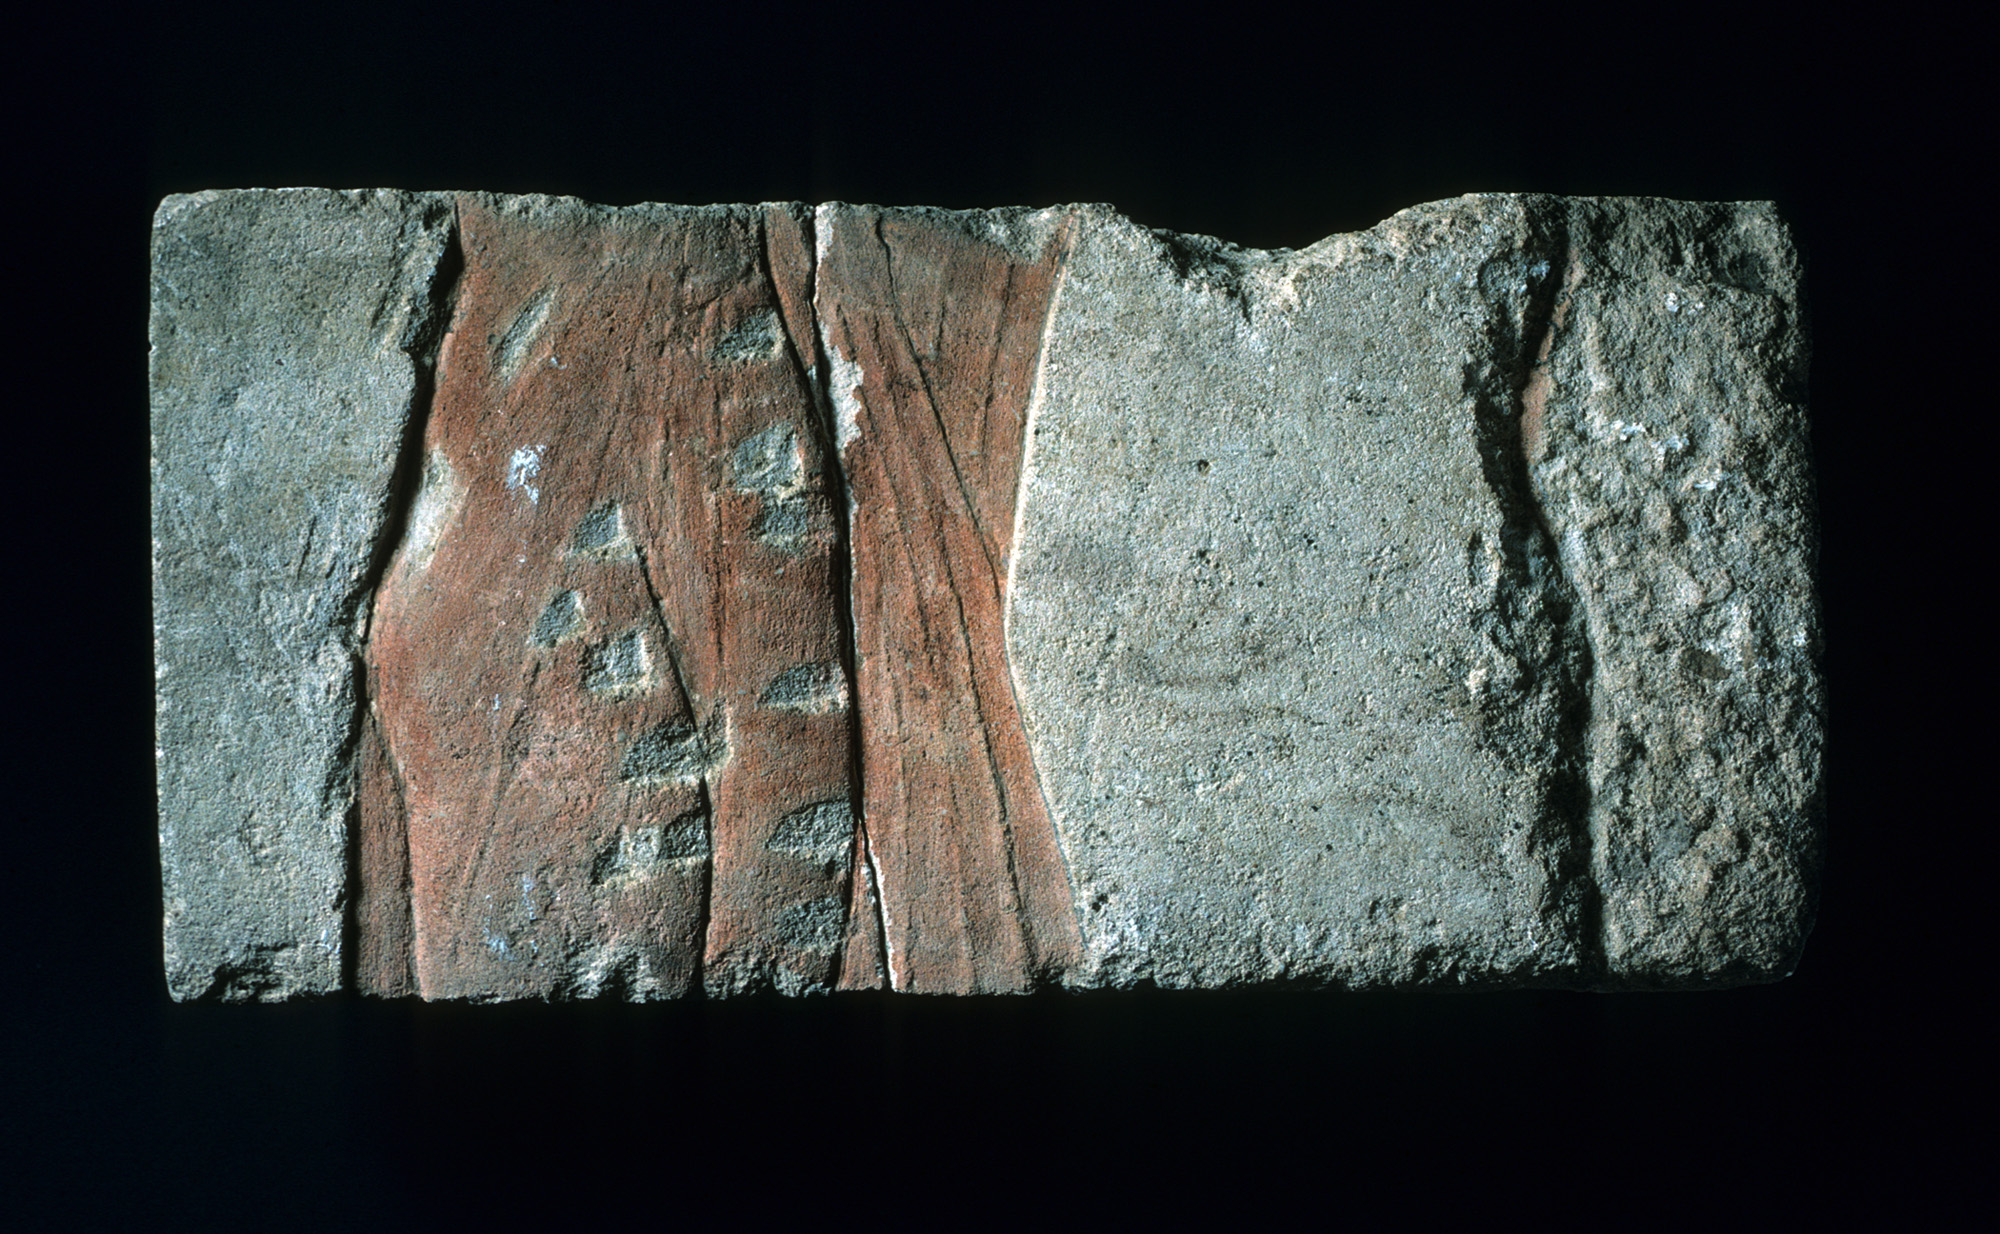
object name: talatat, royal figure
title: Relief with royal figures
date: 1353-1336 BCE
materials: limestone, paint